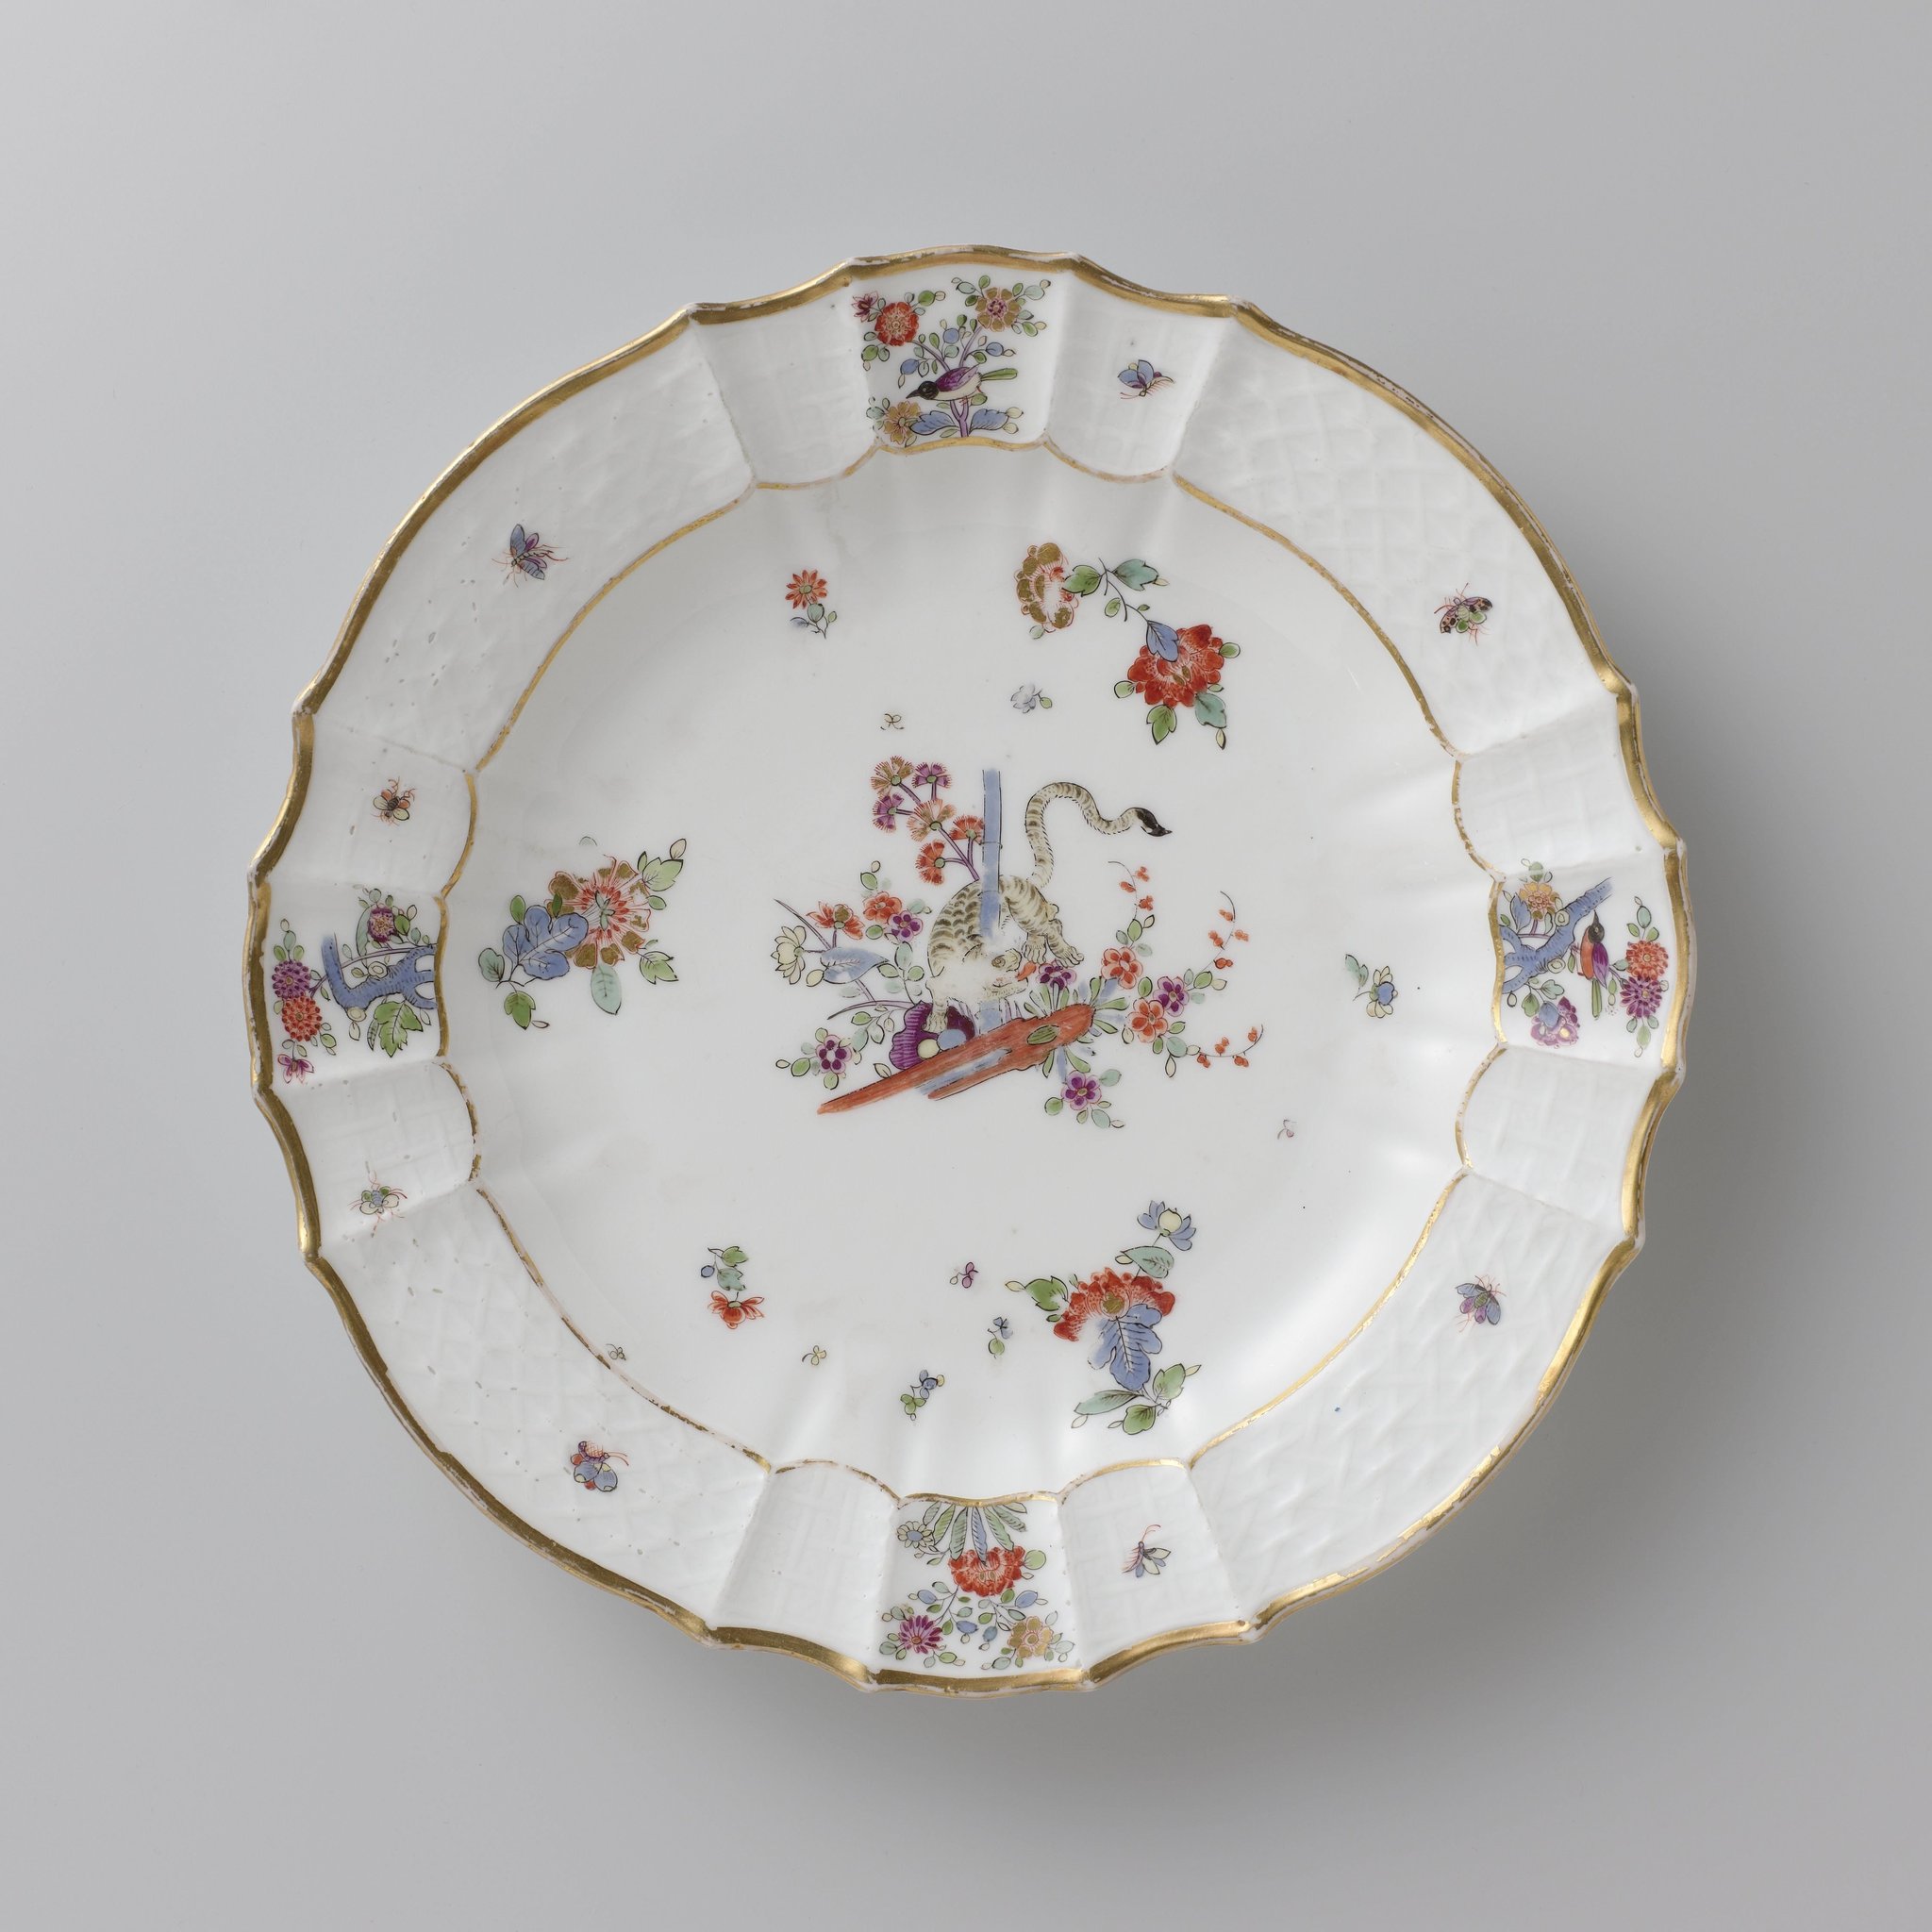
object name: plate dish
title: Rond bord, veelkleurig beschilderd met een Kakiemon-decor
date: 1740-1745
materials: porcelain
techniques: painted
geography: meissen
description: Rond bord van beschilderd porselein. Het bord is geribd en heeft een geschulpte rand. Het bord is beschilderd met een tijger die om een blauwe bamboestengel tussen bloemen is gedraaid, gestrooide Indianische Blumen, vlinders en takken waarop vogels. De rand is versierd met het 'Altbrandenstein'-patroon. Het bord is gemerkt.